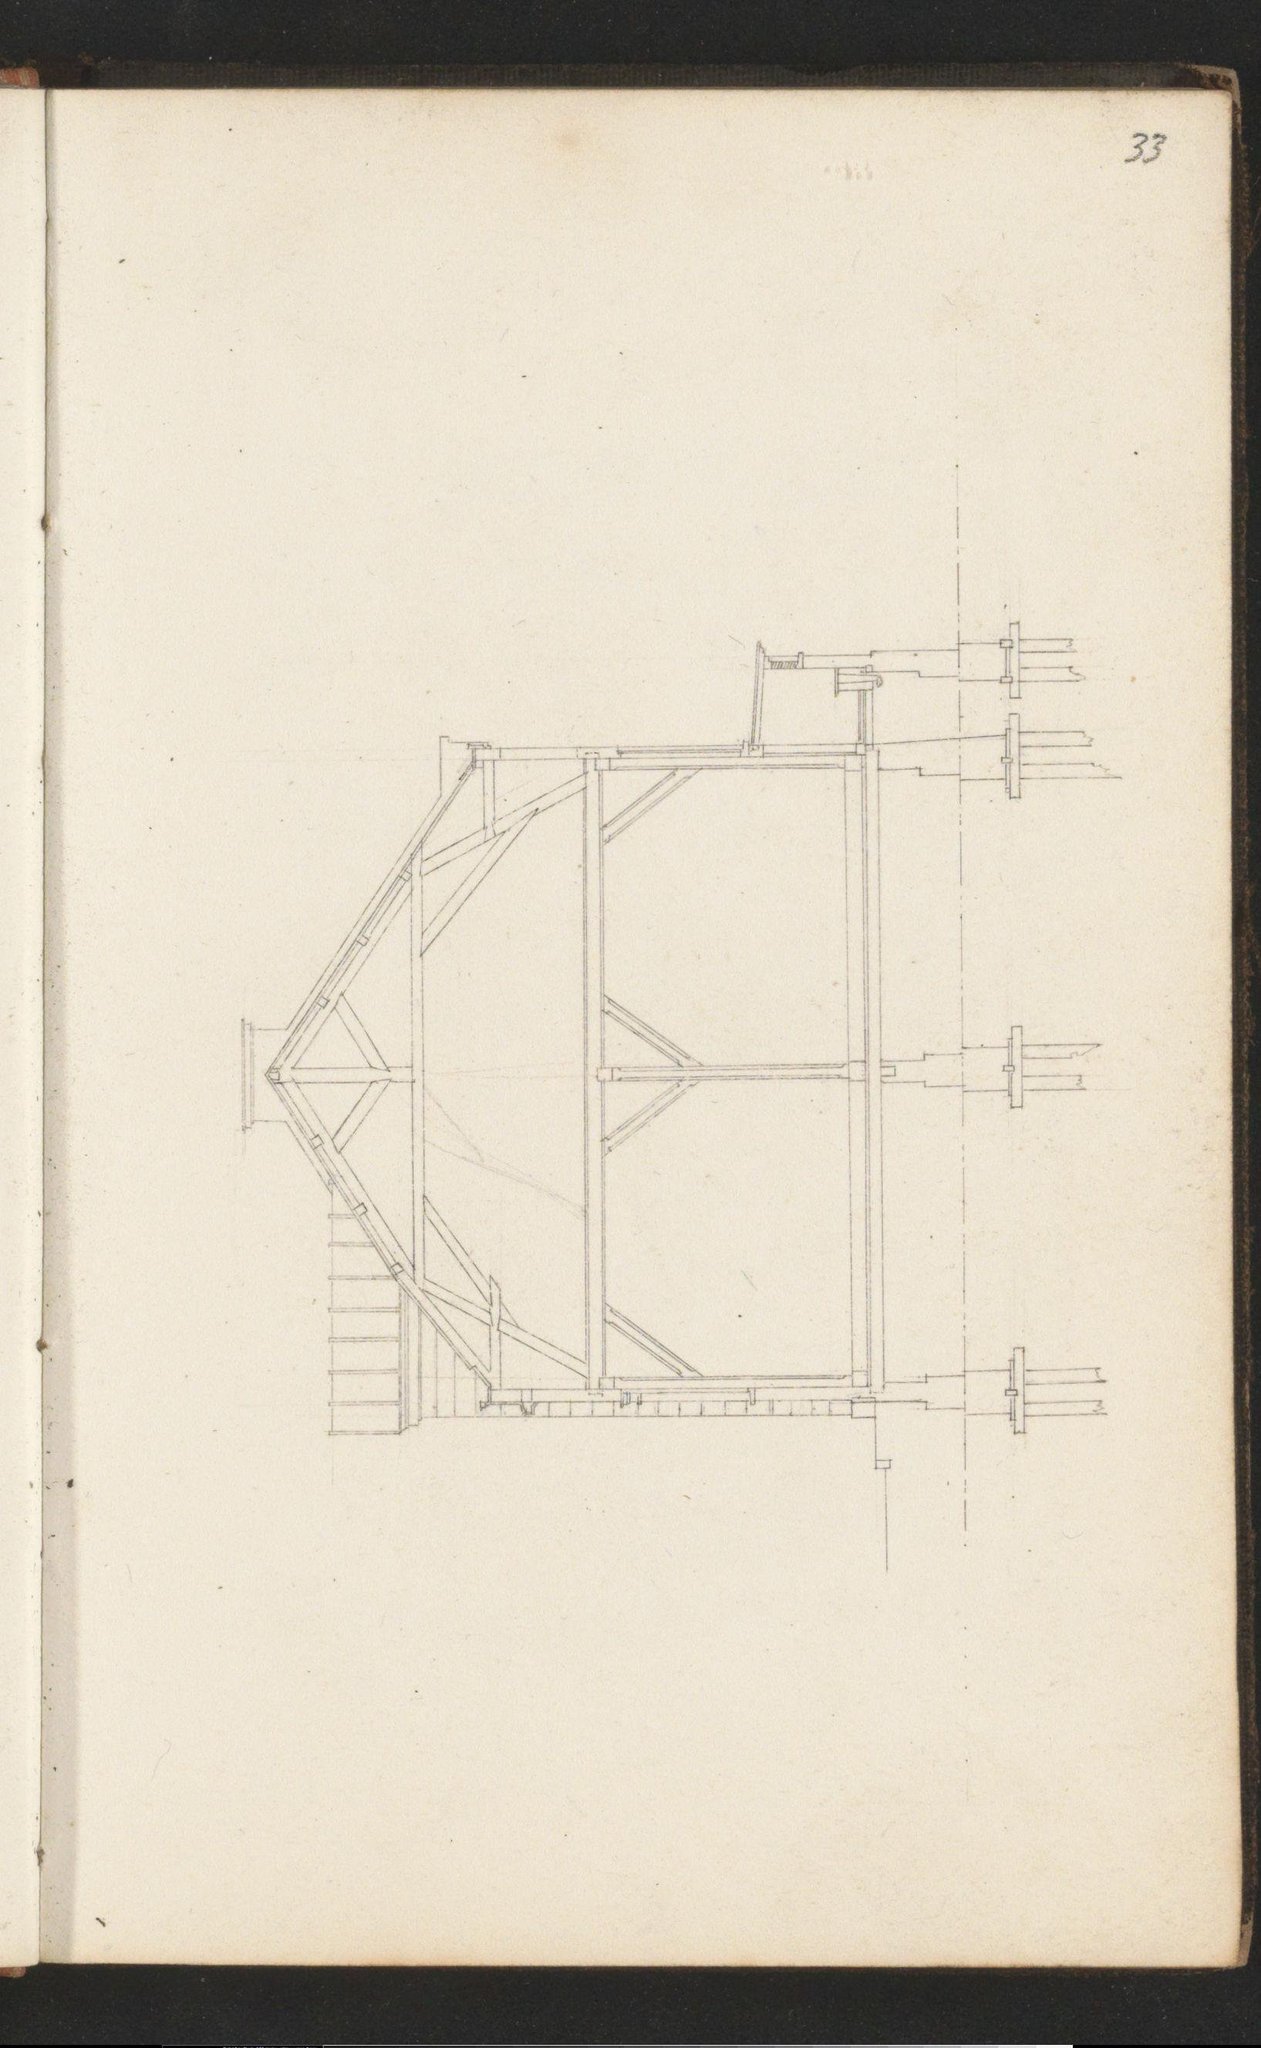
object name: sketchbook leaf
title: Dakconstructie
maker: willem springer jr.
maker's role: draughtsman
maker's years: 1815-1907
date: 1864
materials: ink, paper, pencil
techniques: pen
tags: roof (of house or building)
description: Pagina 33 uit een schetsboek met 164 pagina's.